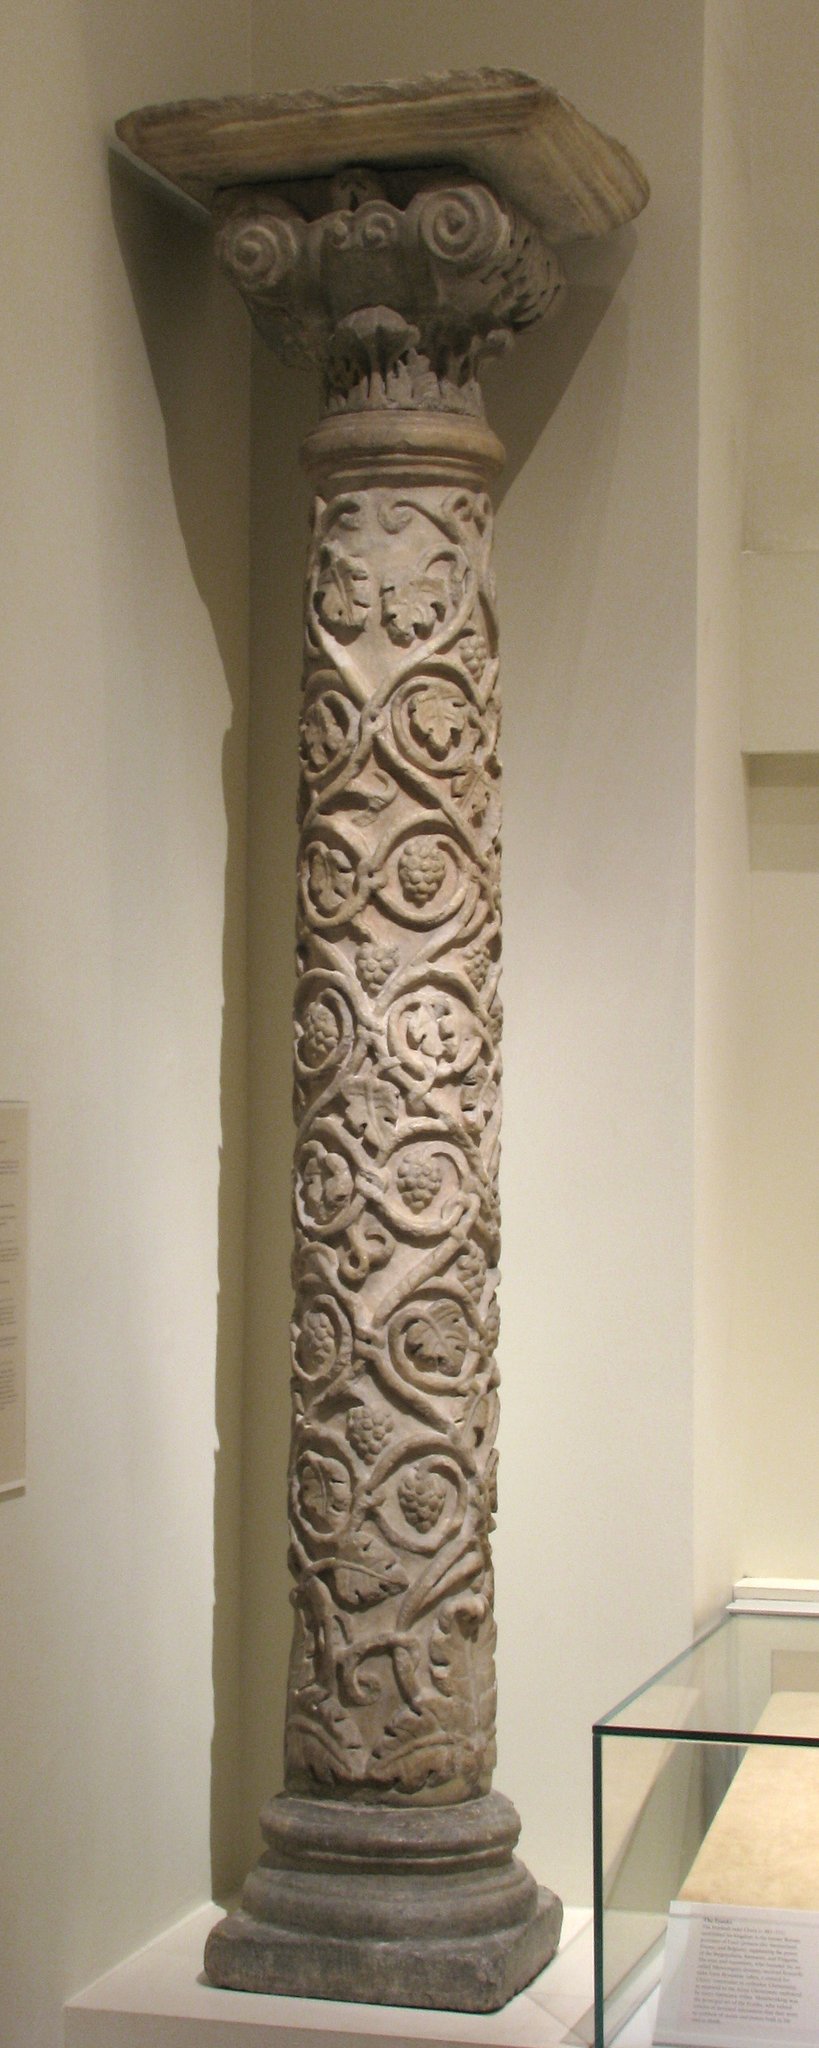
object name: column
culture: frankish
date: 401-600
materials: marble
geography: france